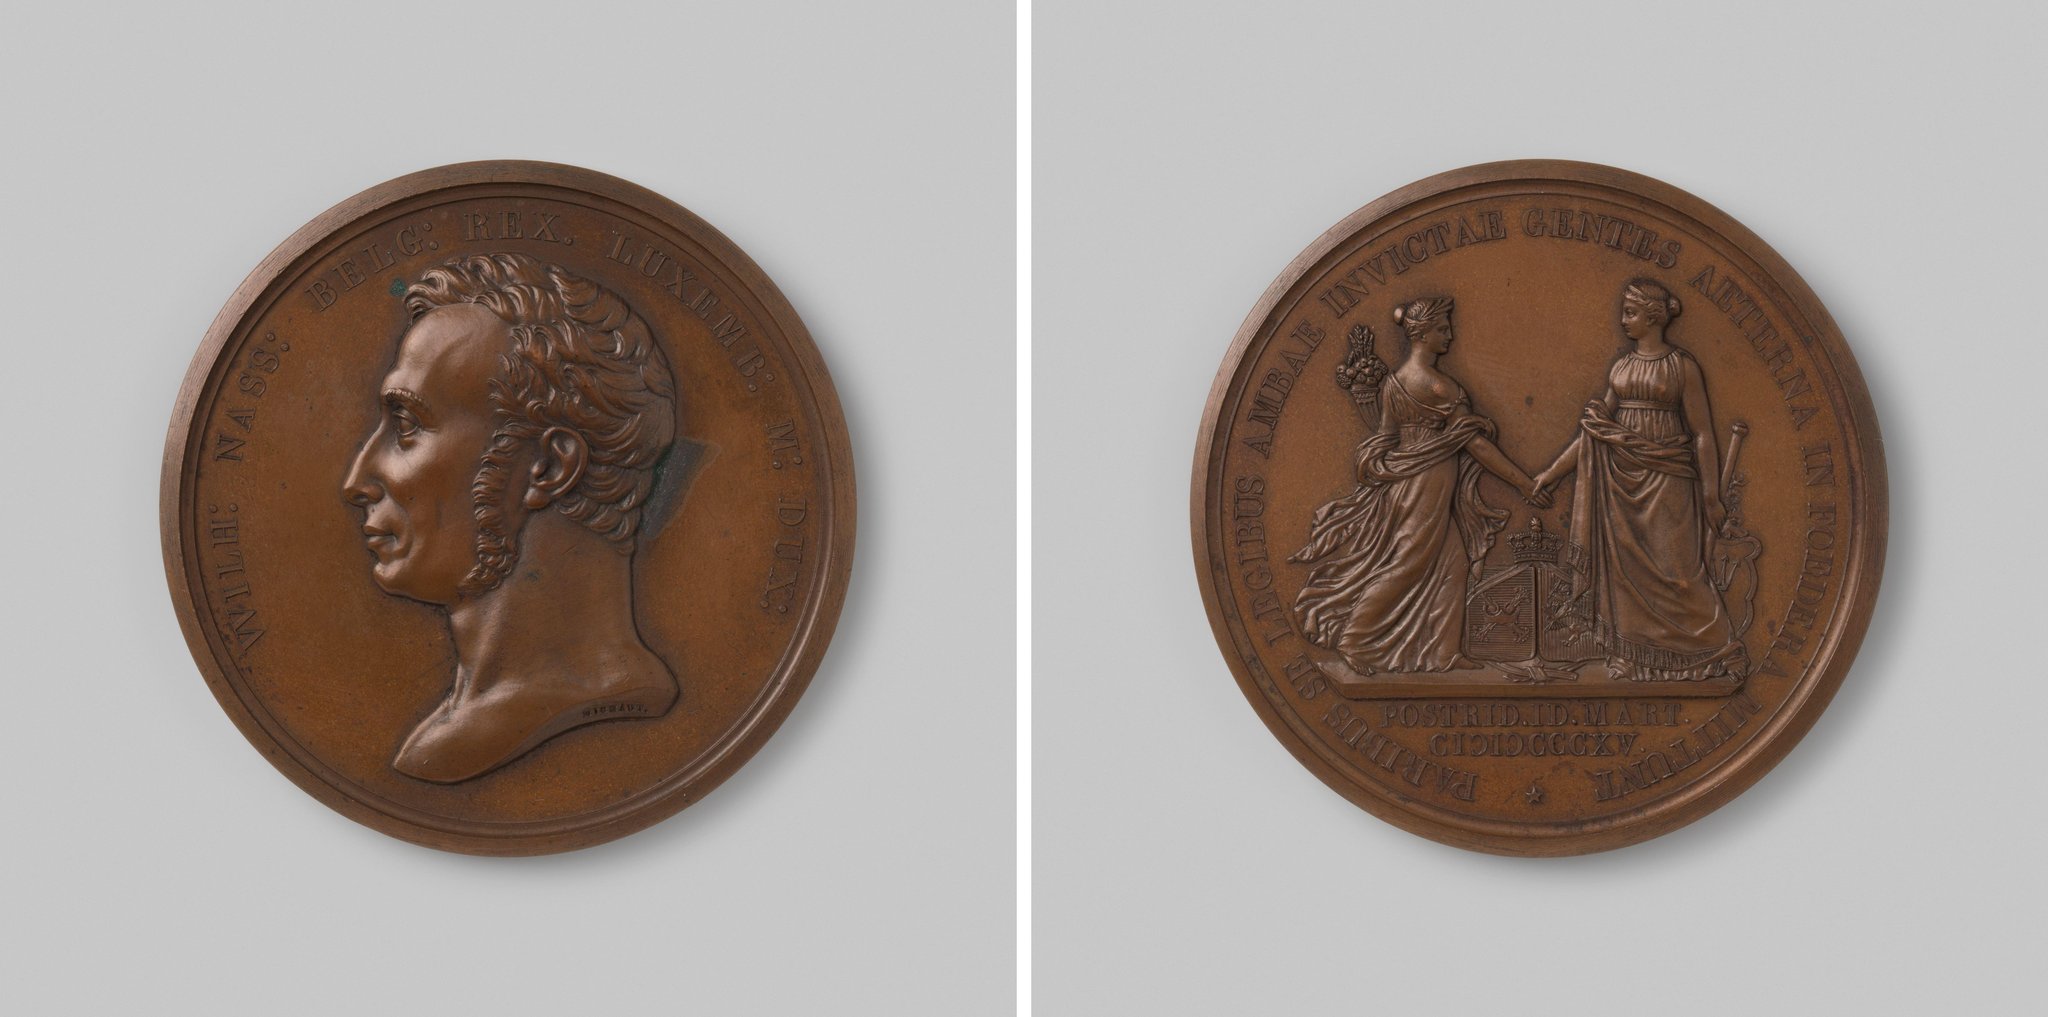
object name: history medal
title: De vereniging der Noordelijke en Zuidelijke Nederlanden onder Koning Willem I 1815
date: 1815-1831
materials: bronze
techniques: striking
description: Grote bronzen penning, op de voorzijde het portret van Willem I naar links, met omschrift, op de keerzijde de Zuidelijke en Noordelijke Nederlanden als vrouwen die elkaar de hand schudden boven de twee samengebonden wapenschilden onder één kroon, met omschrift en afsnedetekst.